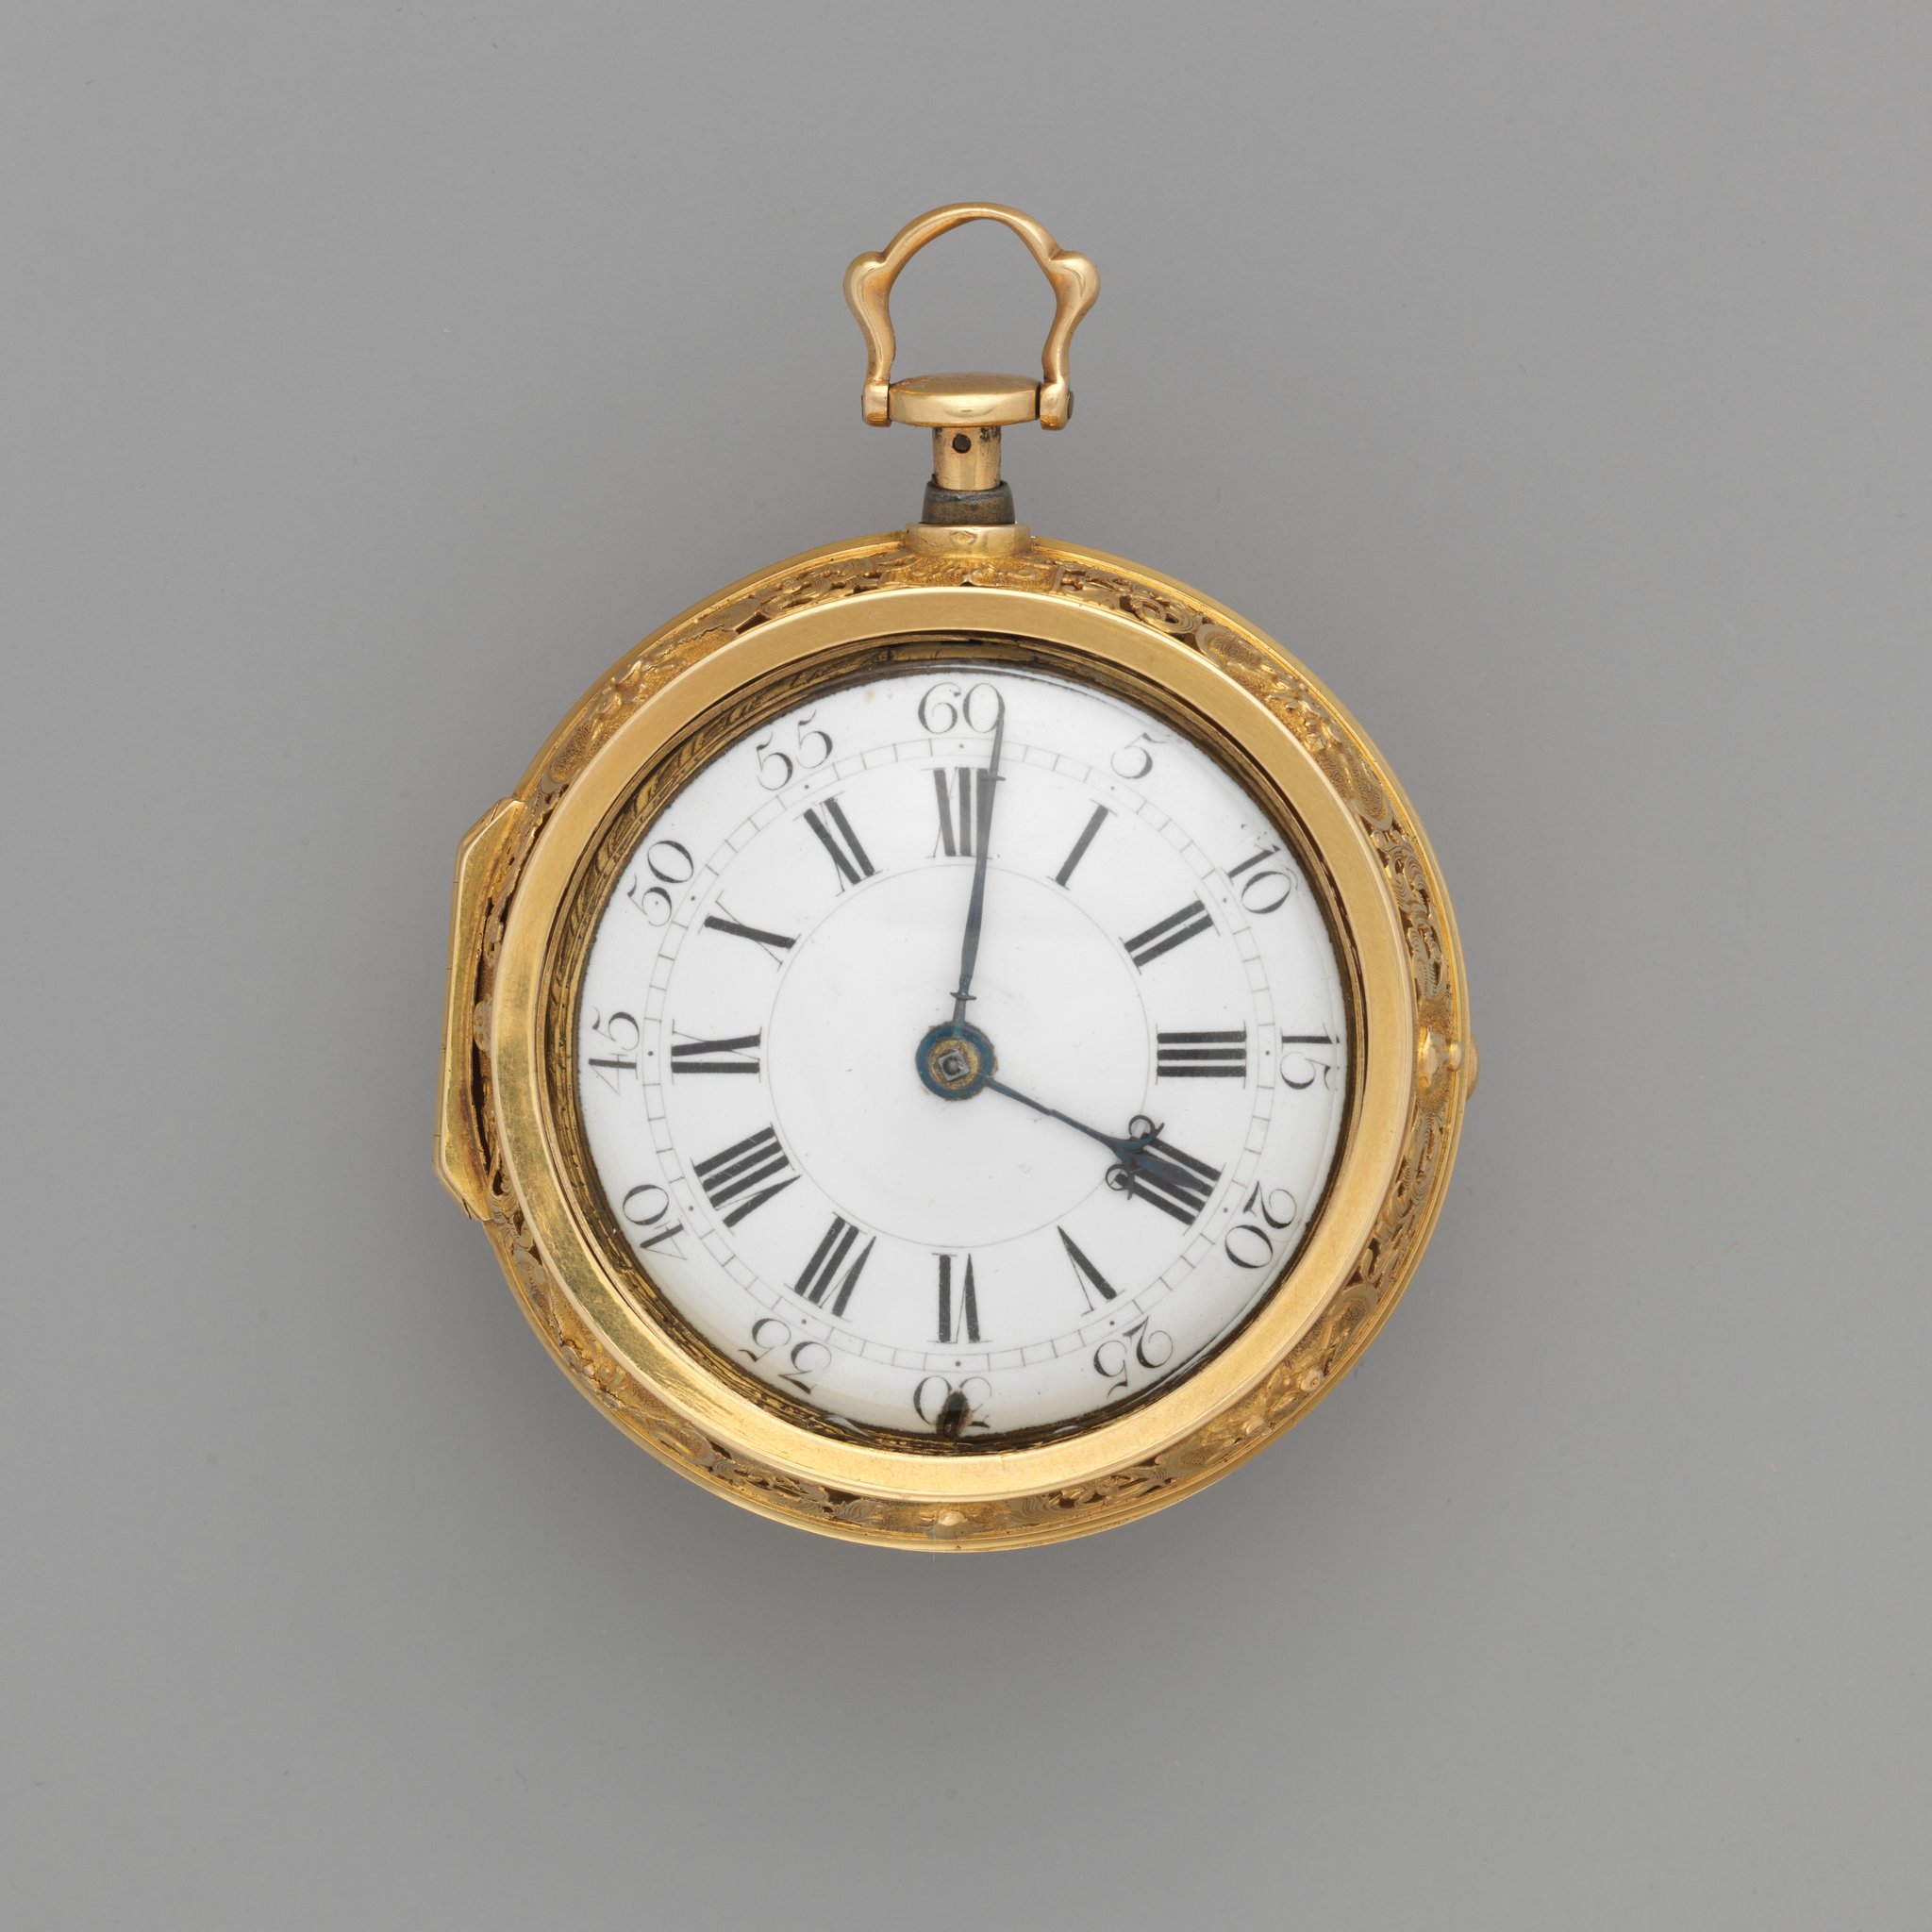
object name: pair case watch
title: Pair-case watch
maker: rodet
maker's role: maker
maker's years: 1735-1745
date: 1740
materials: enamel, gold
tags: birds,faces,leaves